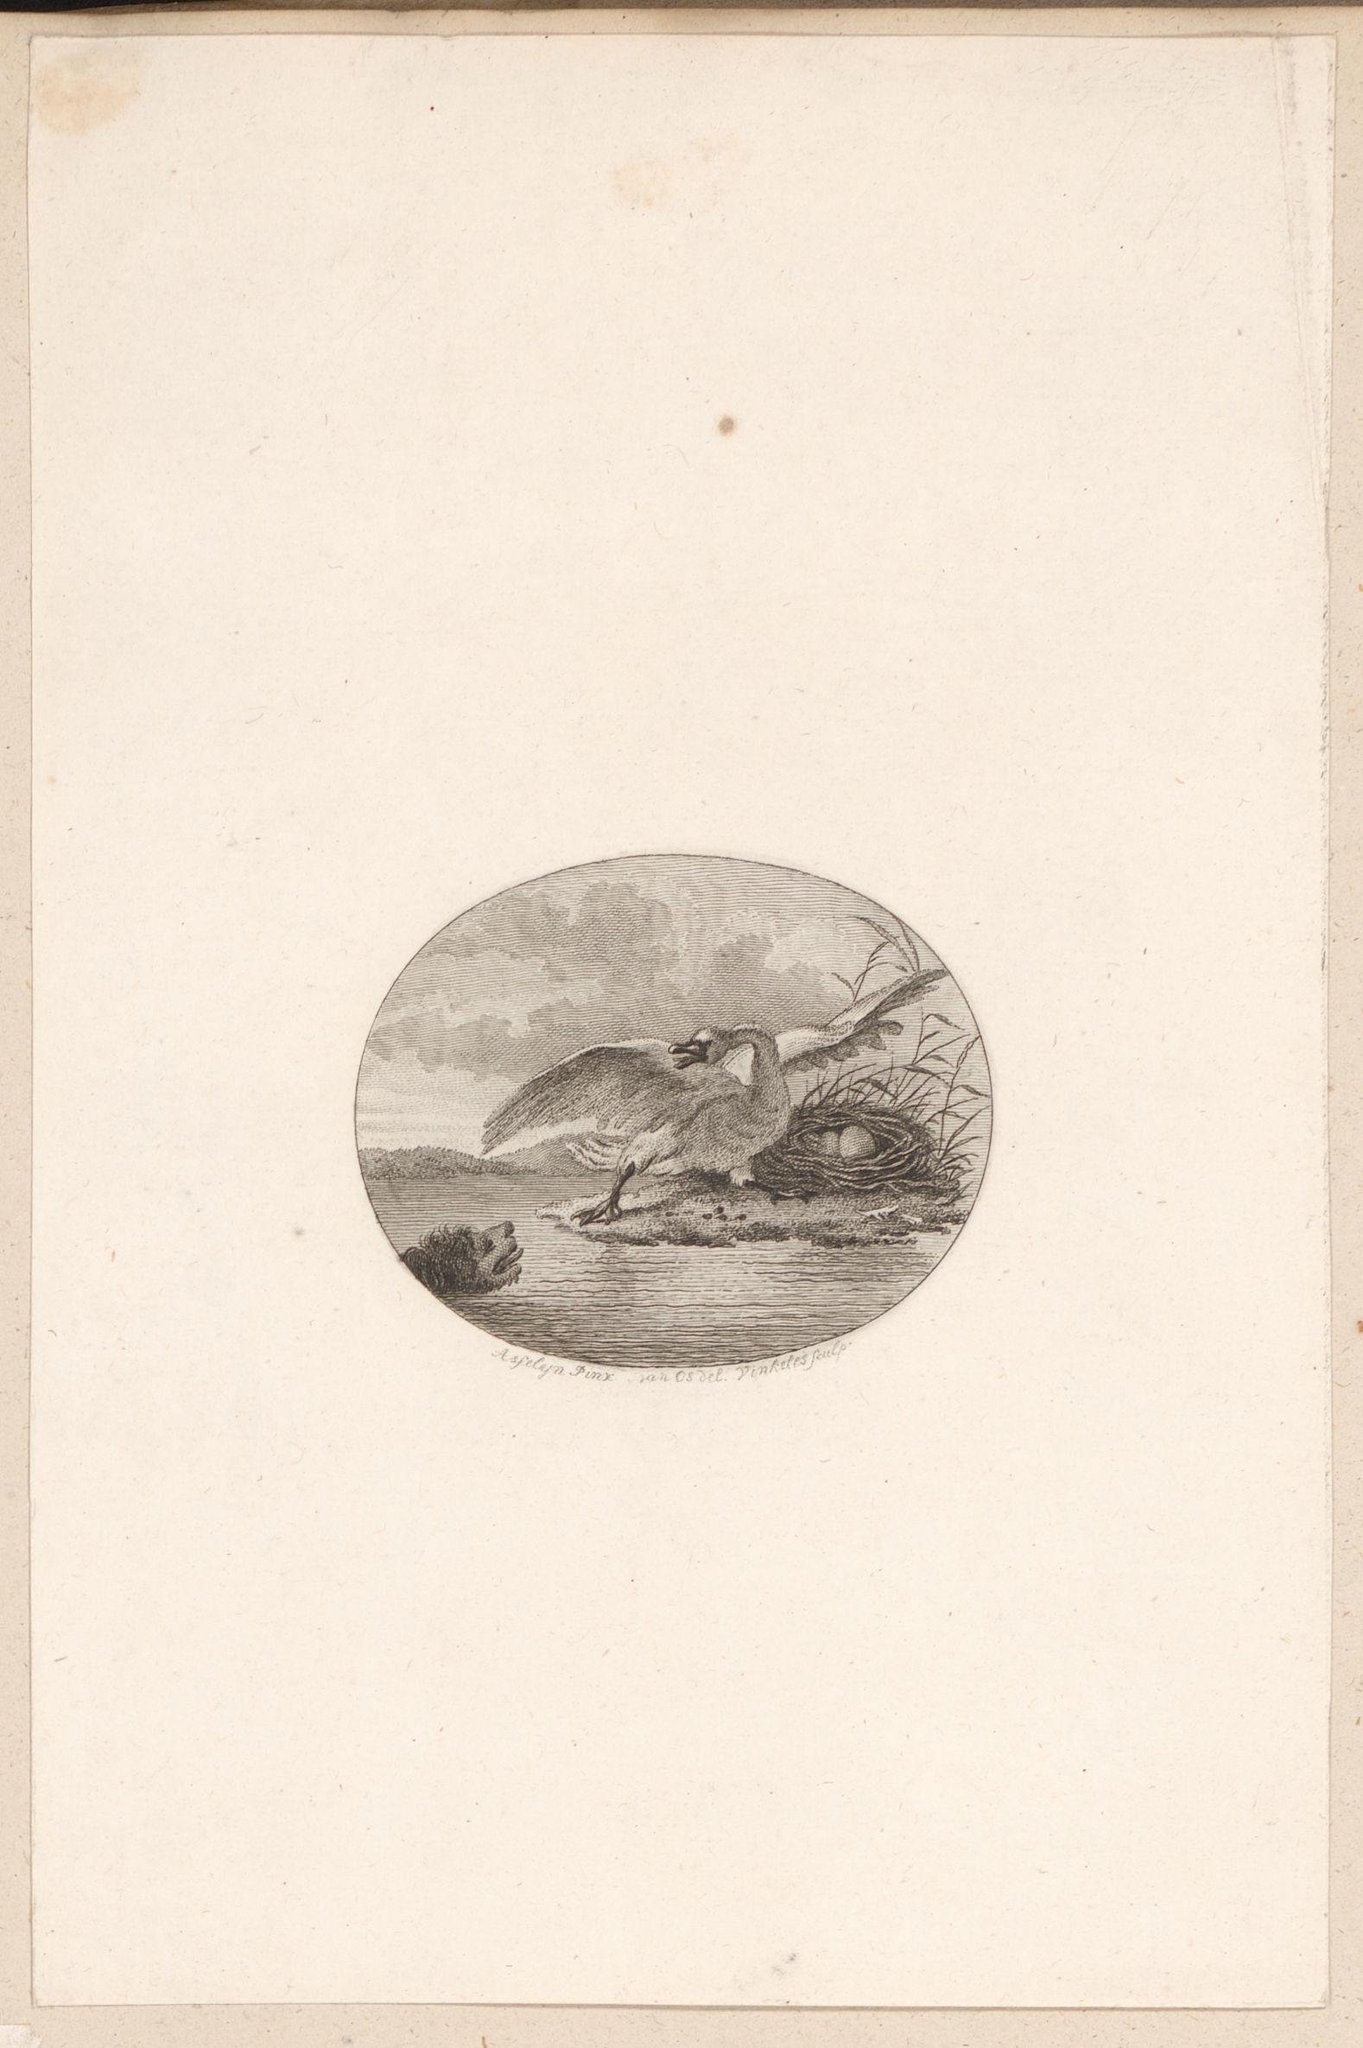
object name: album leaf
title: De bedreigde zwaan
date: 1805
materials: paper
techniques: etching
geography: haarlem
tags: cornelis de witt, the hague, politician, johan de witt, water-birds: swan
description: Een zwaan verdedigt haar nest met eieren tegen een zwemmende hond. De voorstelling heeft een politieke allegorische interpretatie gekregen doordat de zwaan is geïnterpreteerd als de raadpensionaris Johan de Witt, die Holland beschermt tegen de vijand, de Engelse hond. De prent maakt deel uit van een album.